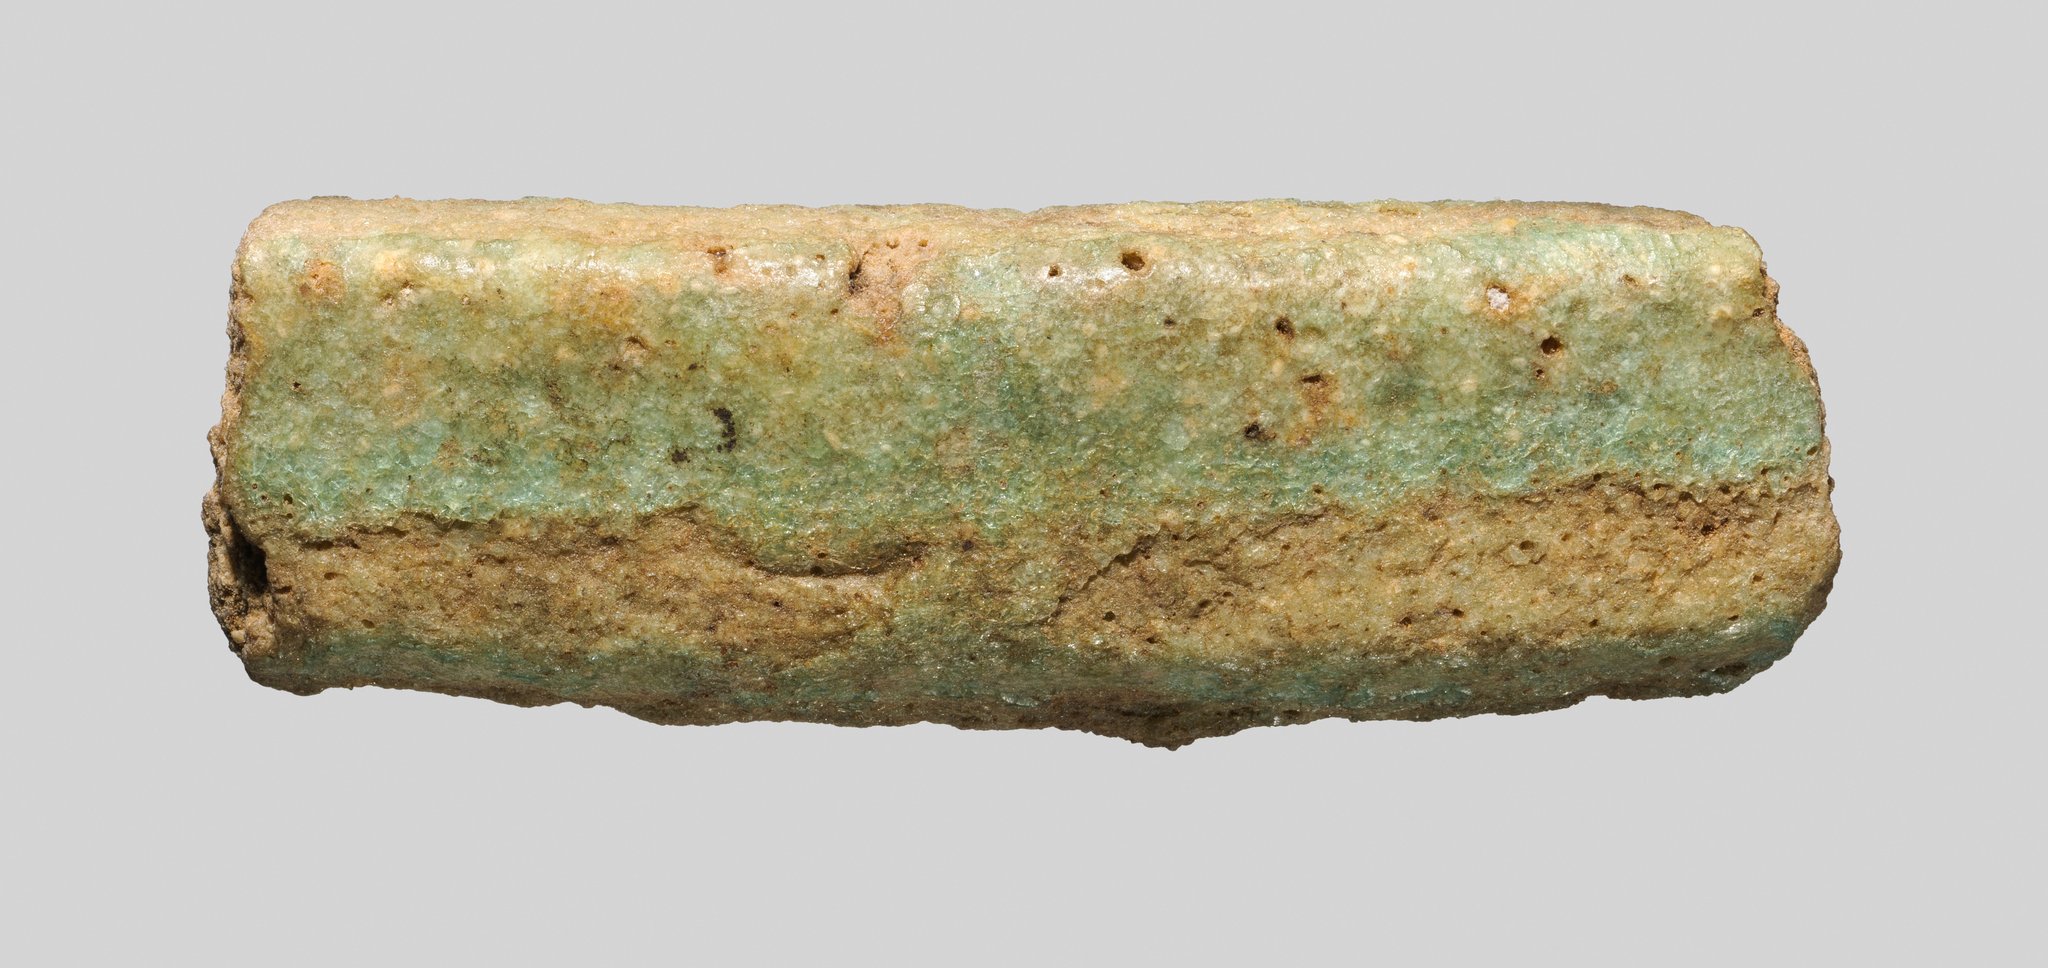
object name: vase fragment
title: Faience lip of a vase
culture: cypriot or egyptian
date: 1300-1101 BCE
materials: faience